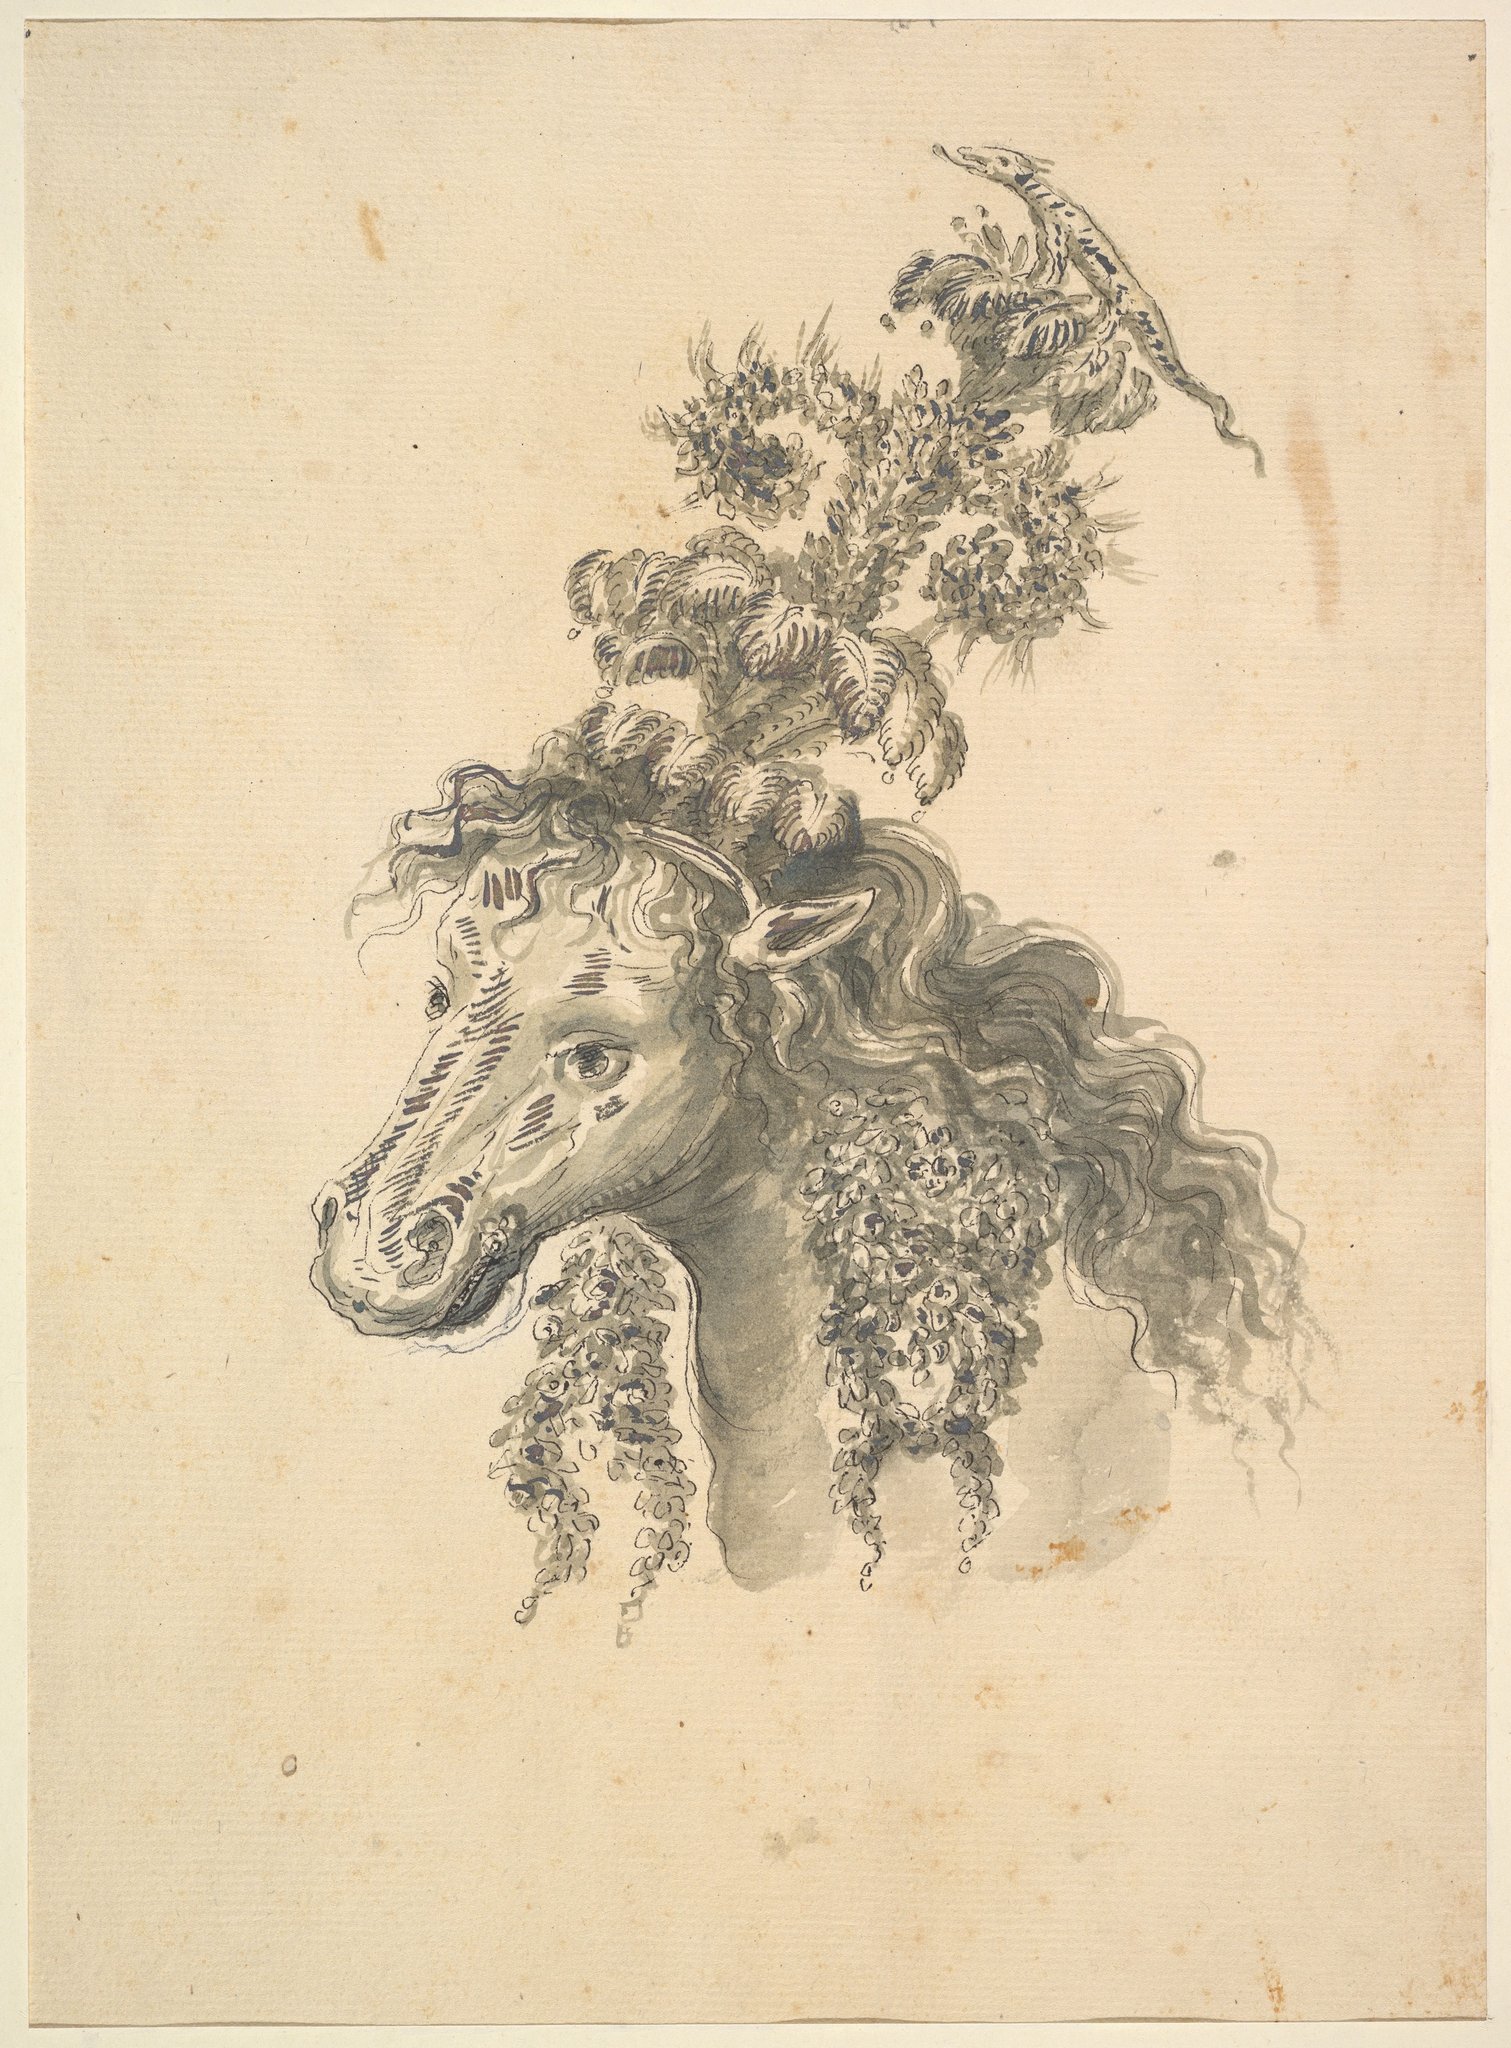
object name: collection ornament architecture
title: Design for the Headdress of a Horse Crowned by a Small Lizard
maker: baccio del bianco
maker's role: artist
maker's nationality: italian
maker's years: 1604-1656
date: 1620-1800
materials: ink, silver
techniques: heightening, wash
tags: horses,lizards